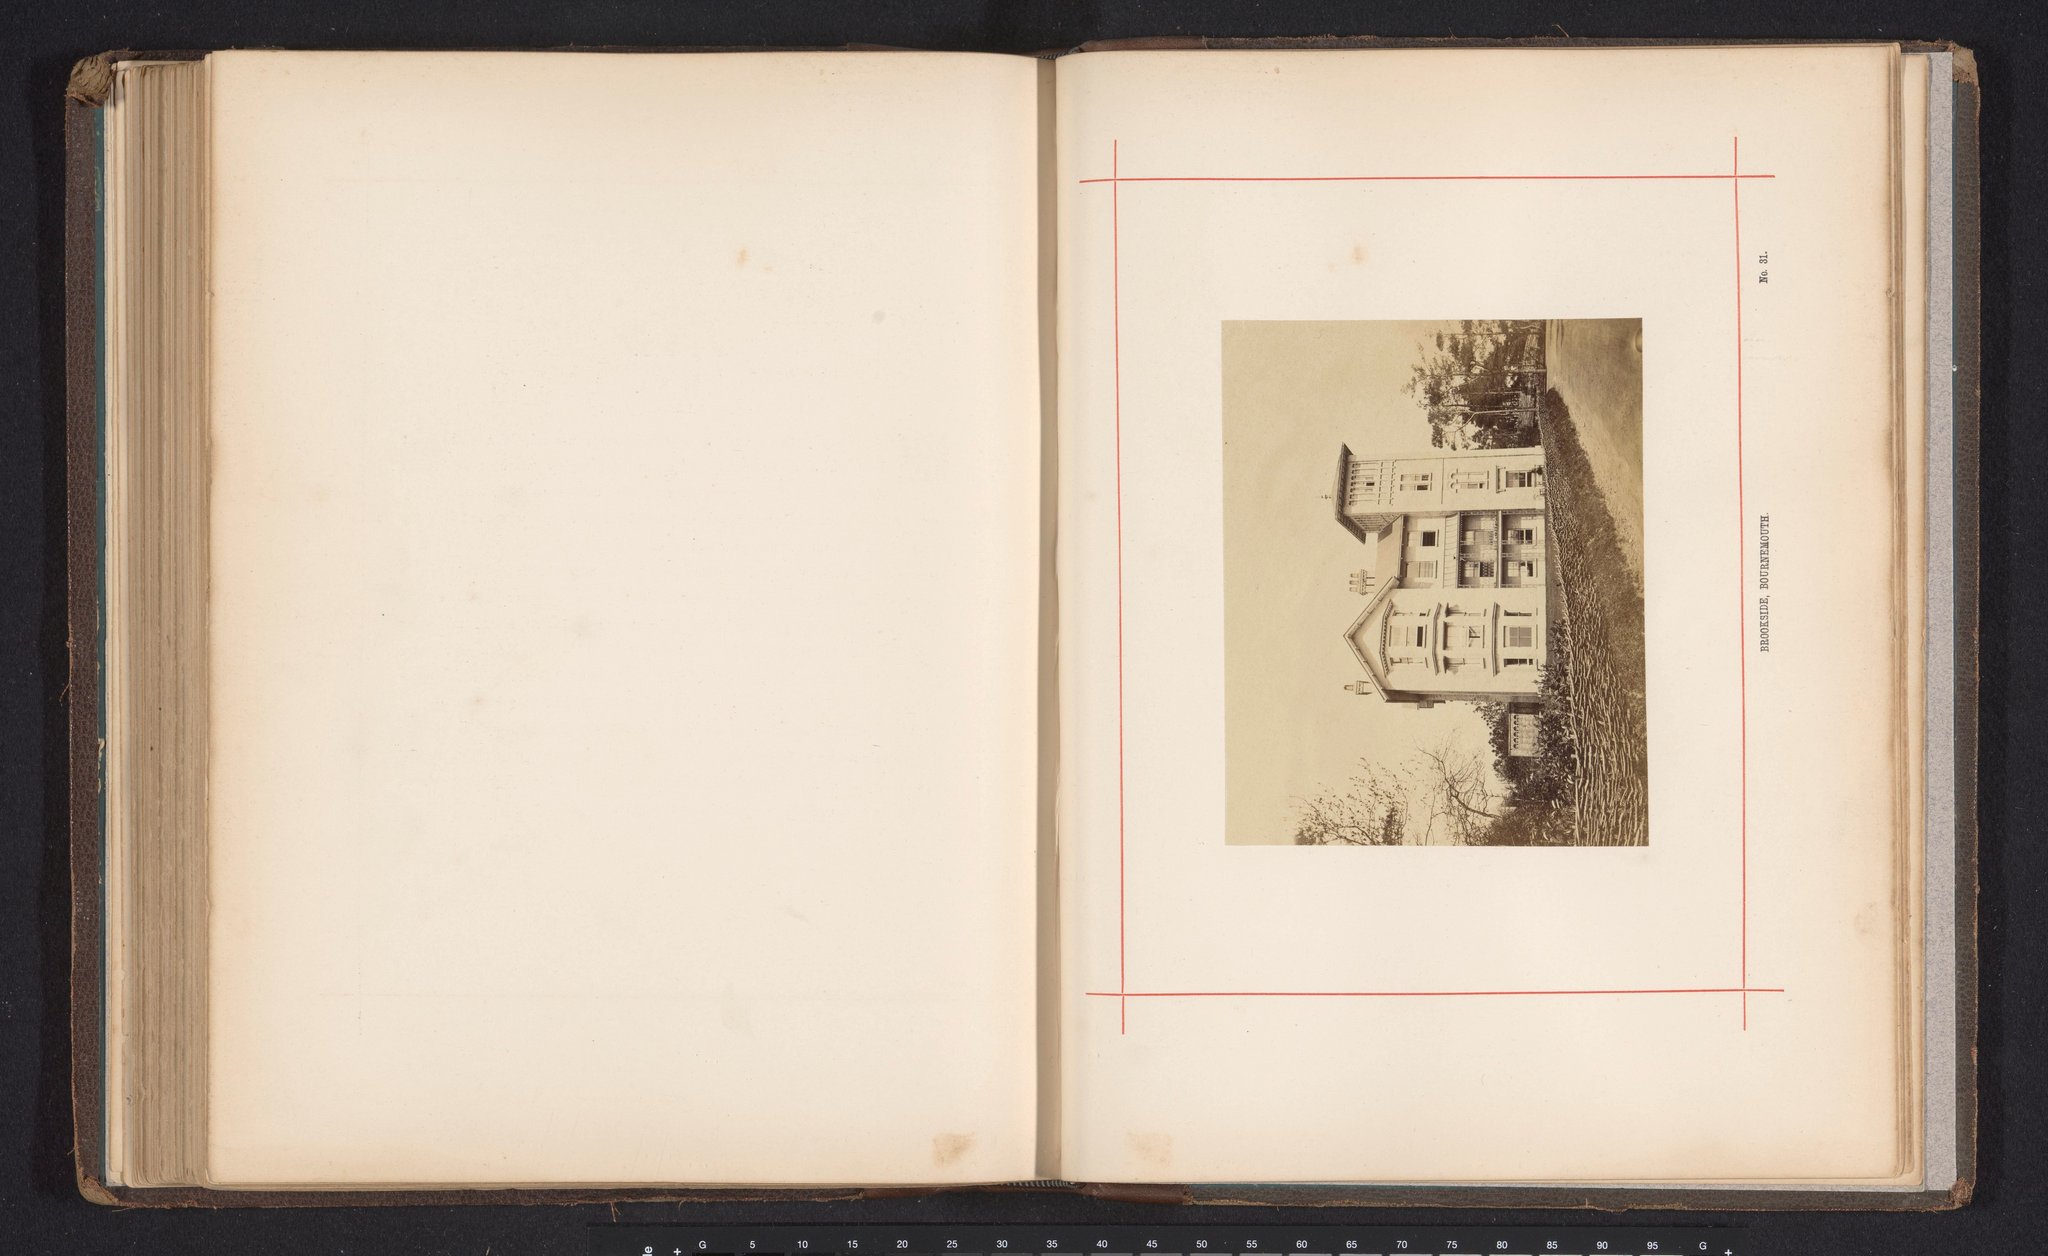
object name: page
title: Brookside, Bournemouth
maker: william savage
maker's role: fotograaf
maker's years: 1817-1887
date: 1861-1866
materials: photographic support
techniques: albumen print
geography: bournemouth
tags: villa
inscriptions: number: ‘No. 31.’